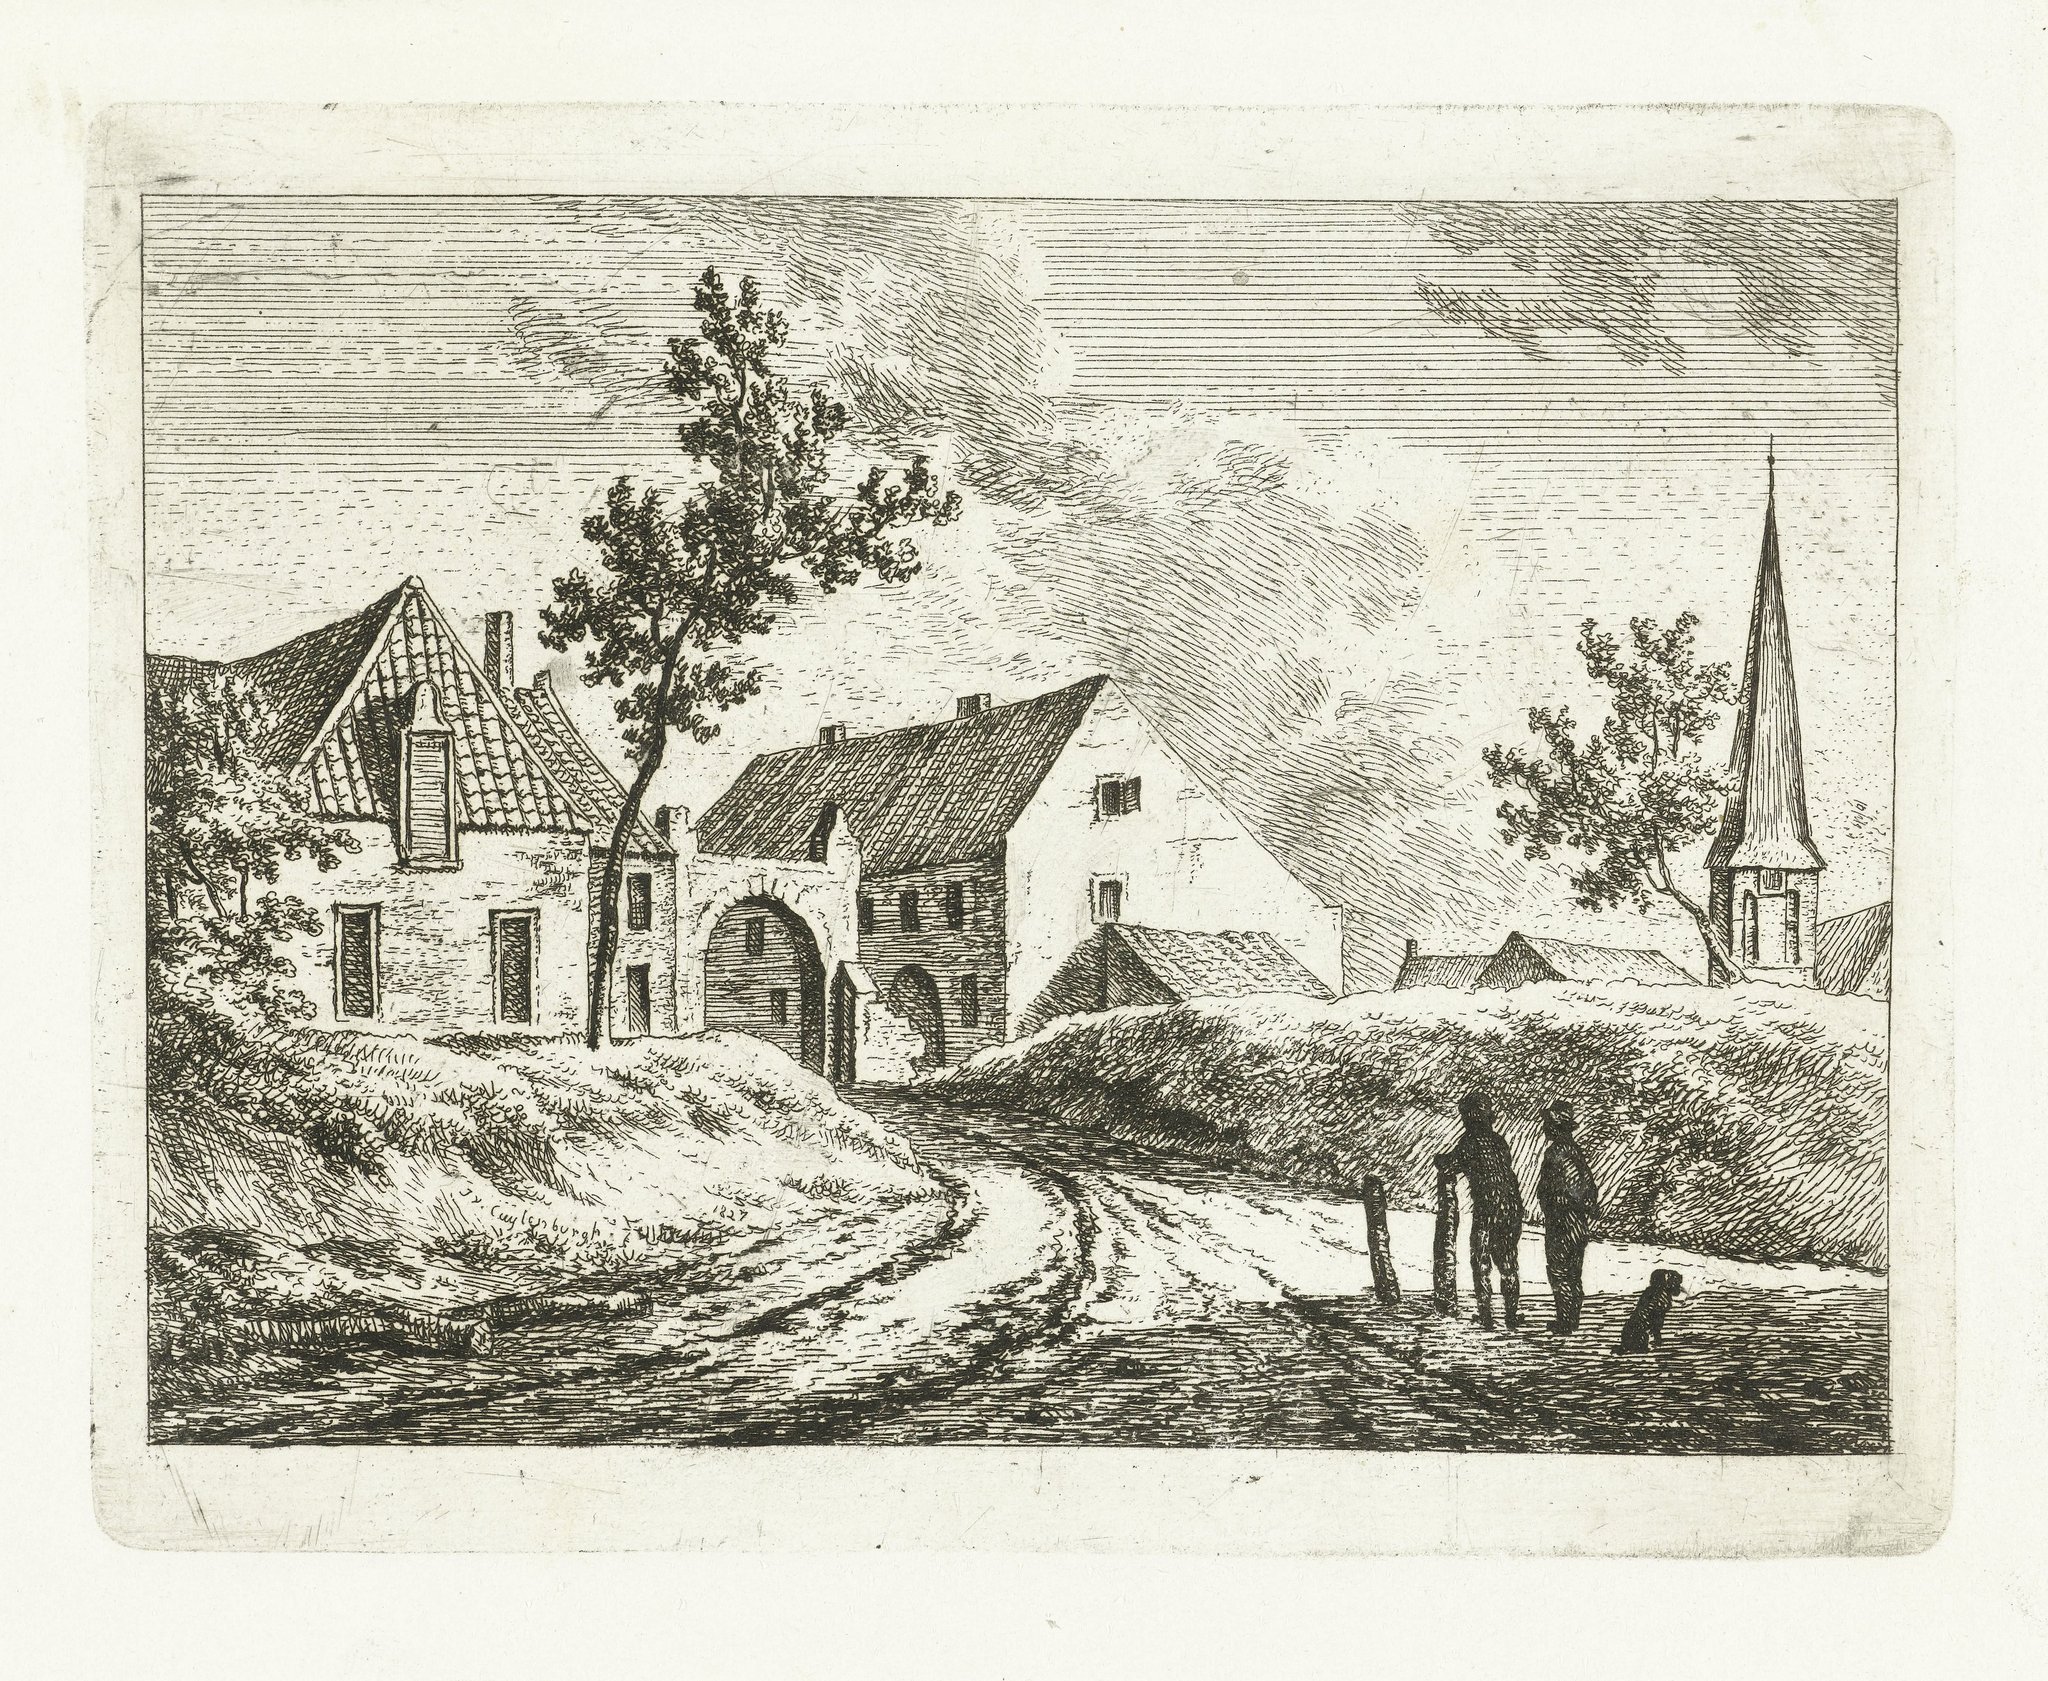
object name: print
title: Landschap met weg naar poort van dorp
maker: johannes van cuylenburgh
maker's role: print maker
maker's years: 1793-1841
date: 1803-1841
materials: paper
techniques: etching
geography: netherlands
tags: village, gate, entrance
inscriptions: collector's mark: Lugt 2228